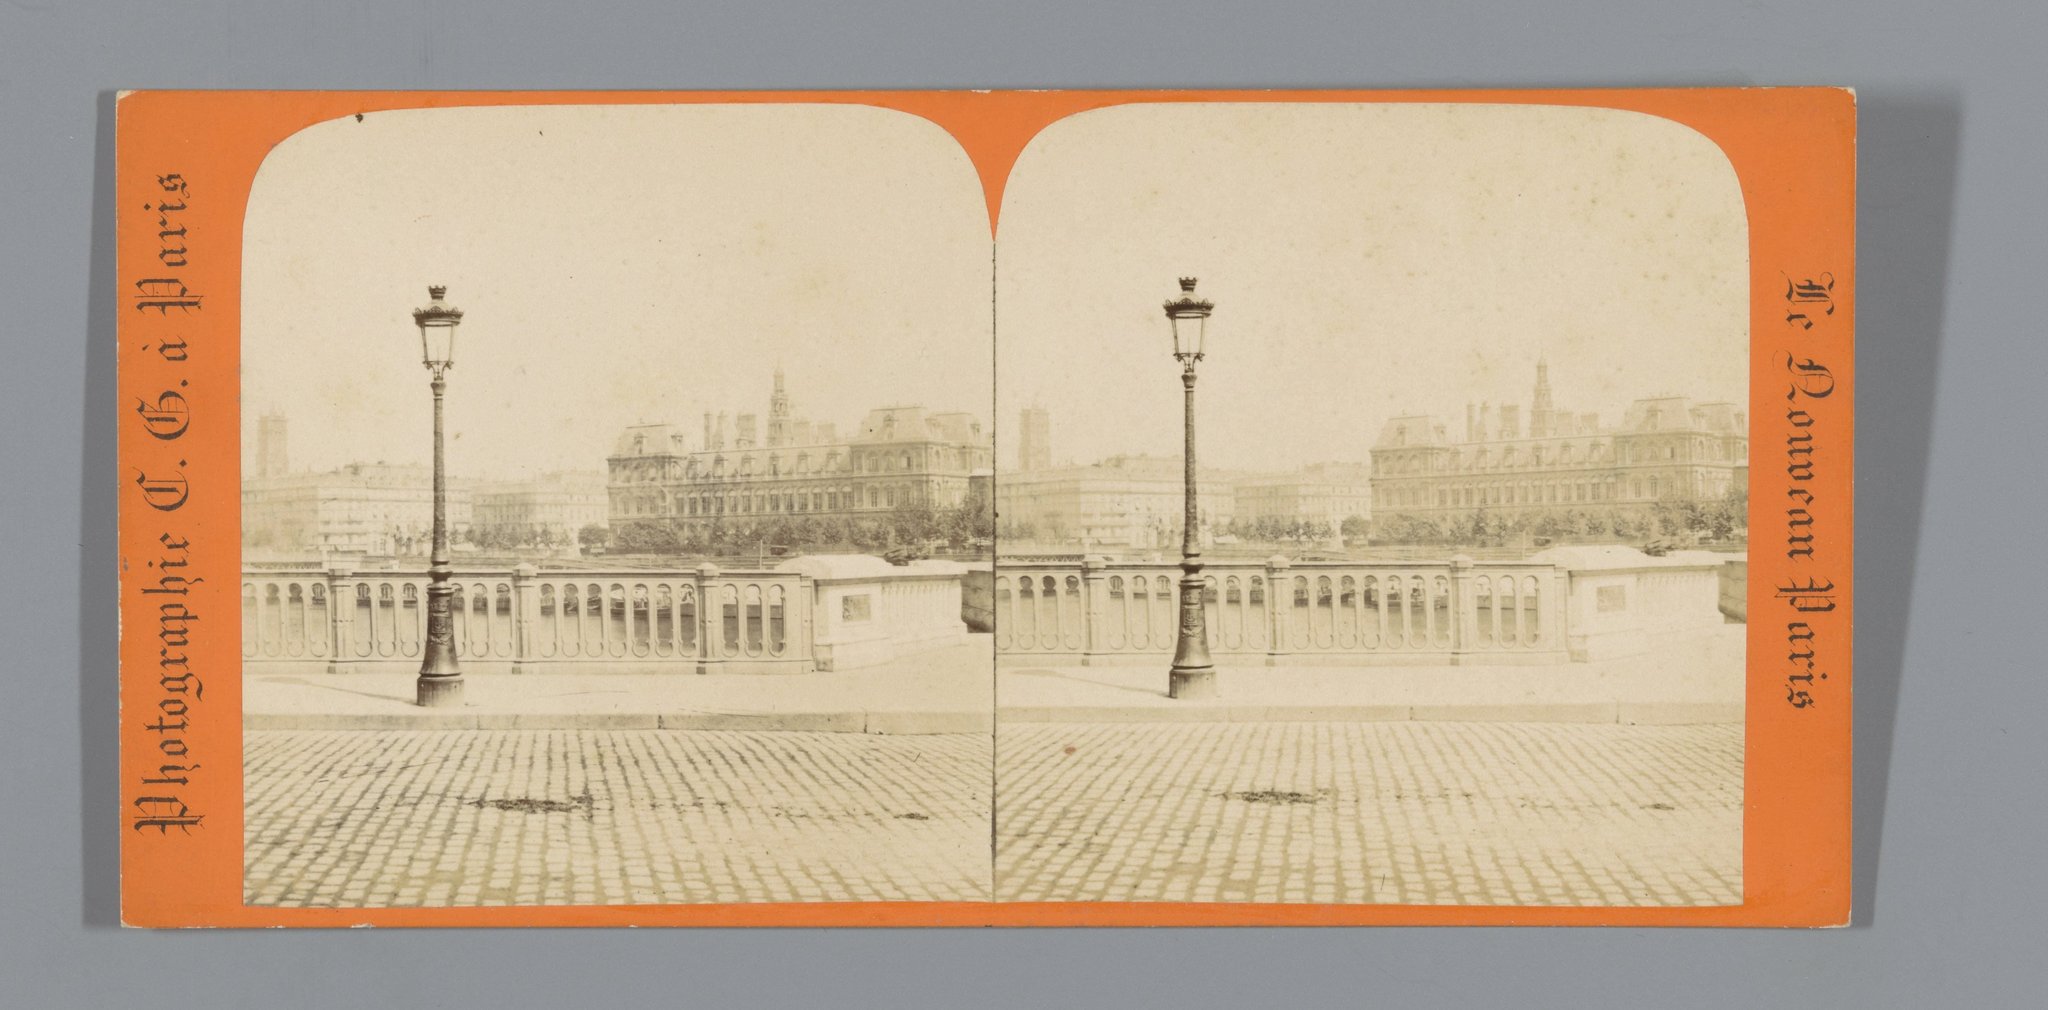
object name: stereograph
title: Kade langs de Seine te Parijs, met op de achtergrond het stadhuis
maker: charles gérard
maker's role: fotograaf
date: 1860-1870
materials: cardboard, photographic support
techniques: albumen print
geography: paris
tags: townhall, quay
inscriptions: inscription: ‘Photographie C. G. à Paris.’, inscription: ‘Hôtel de ville’